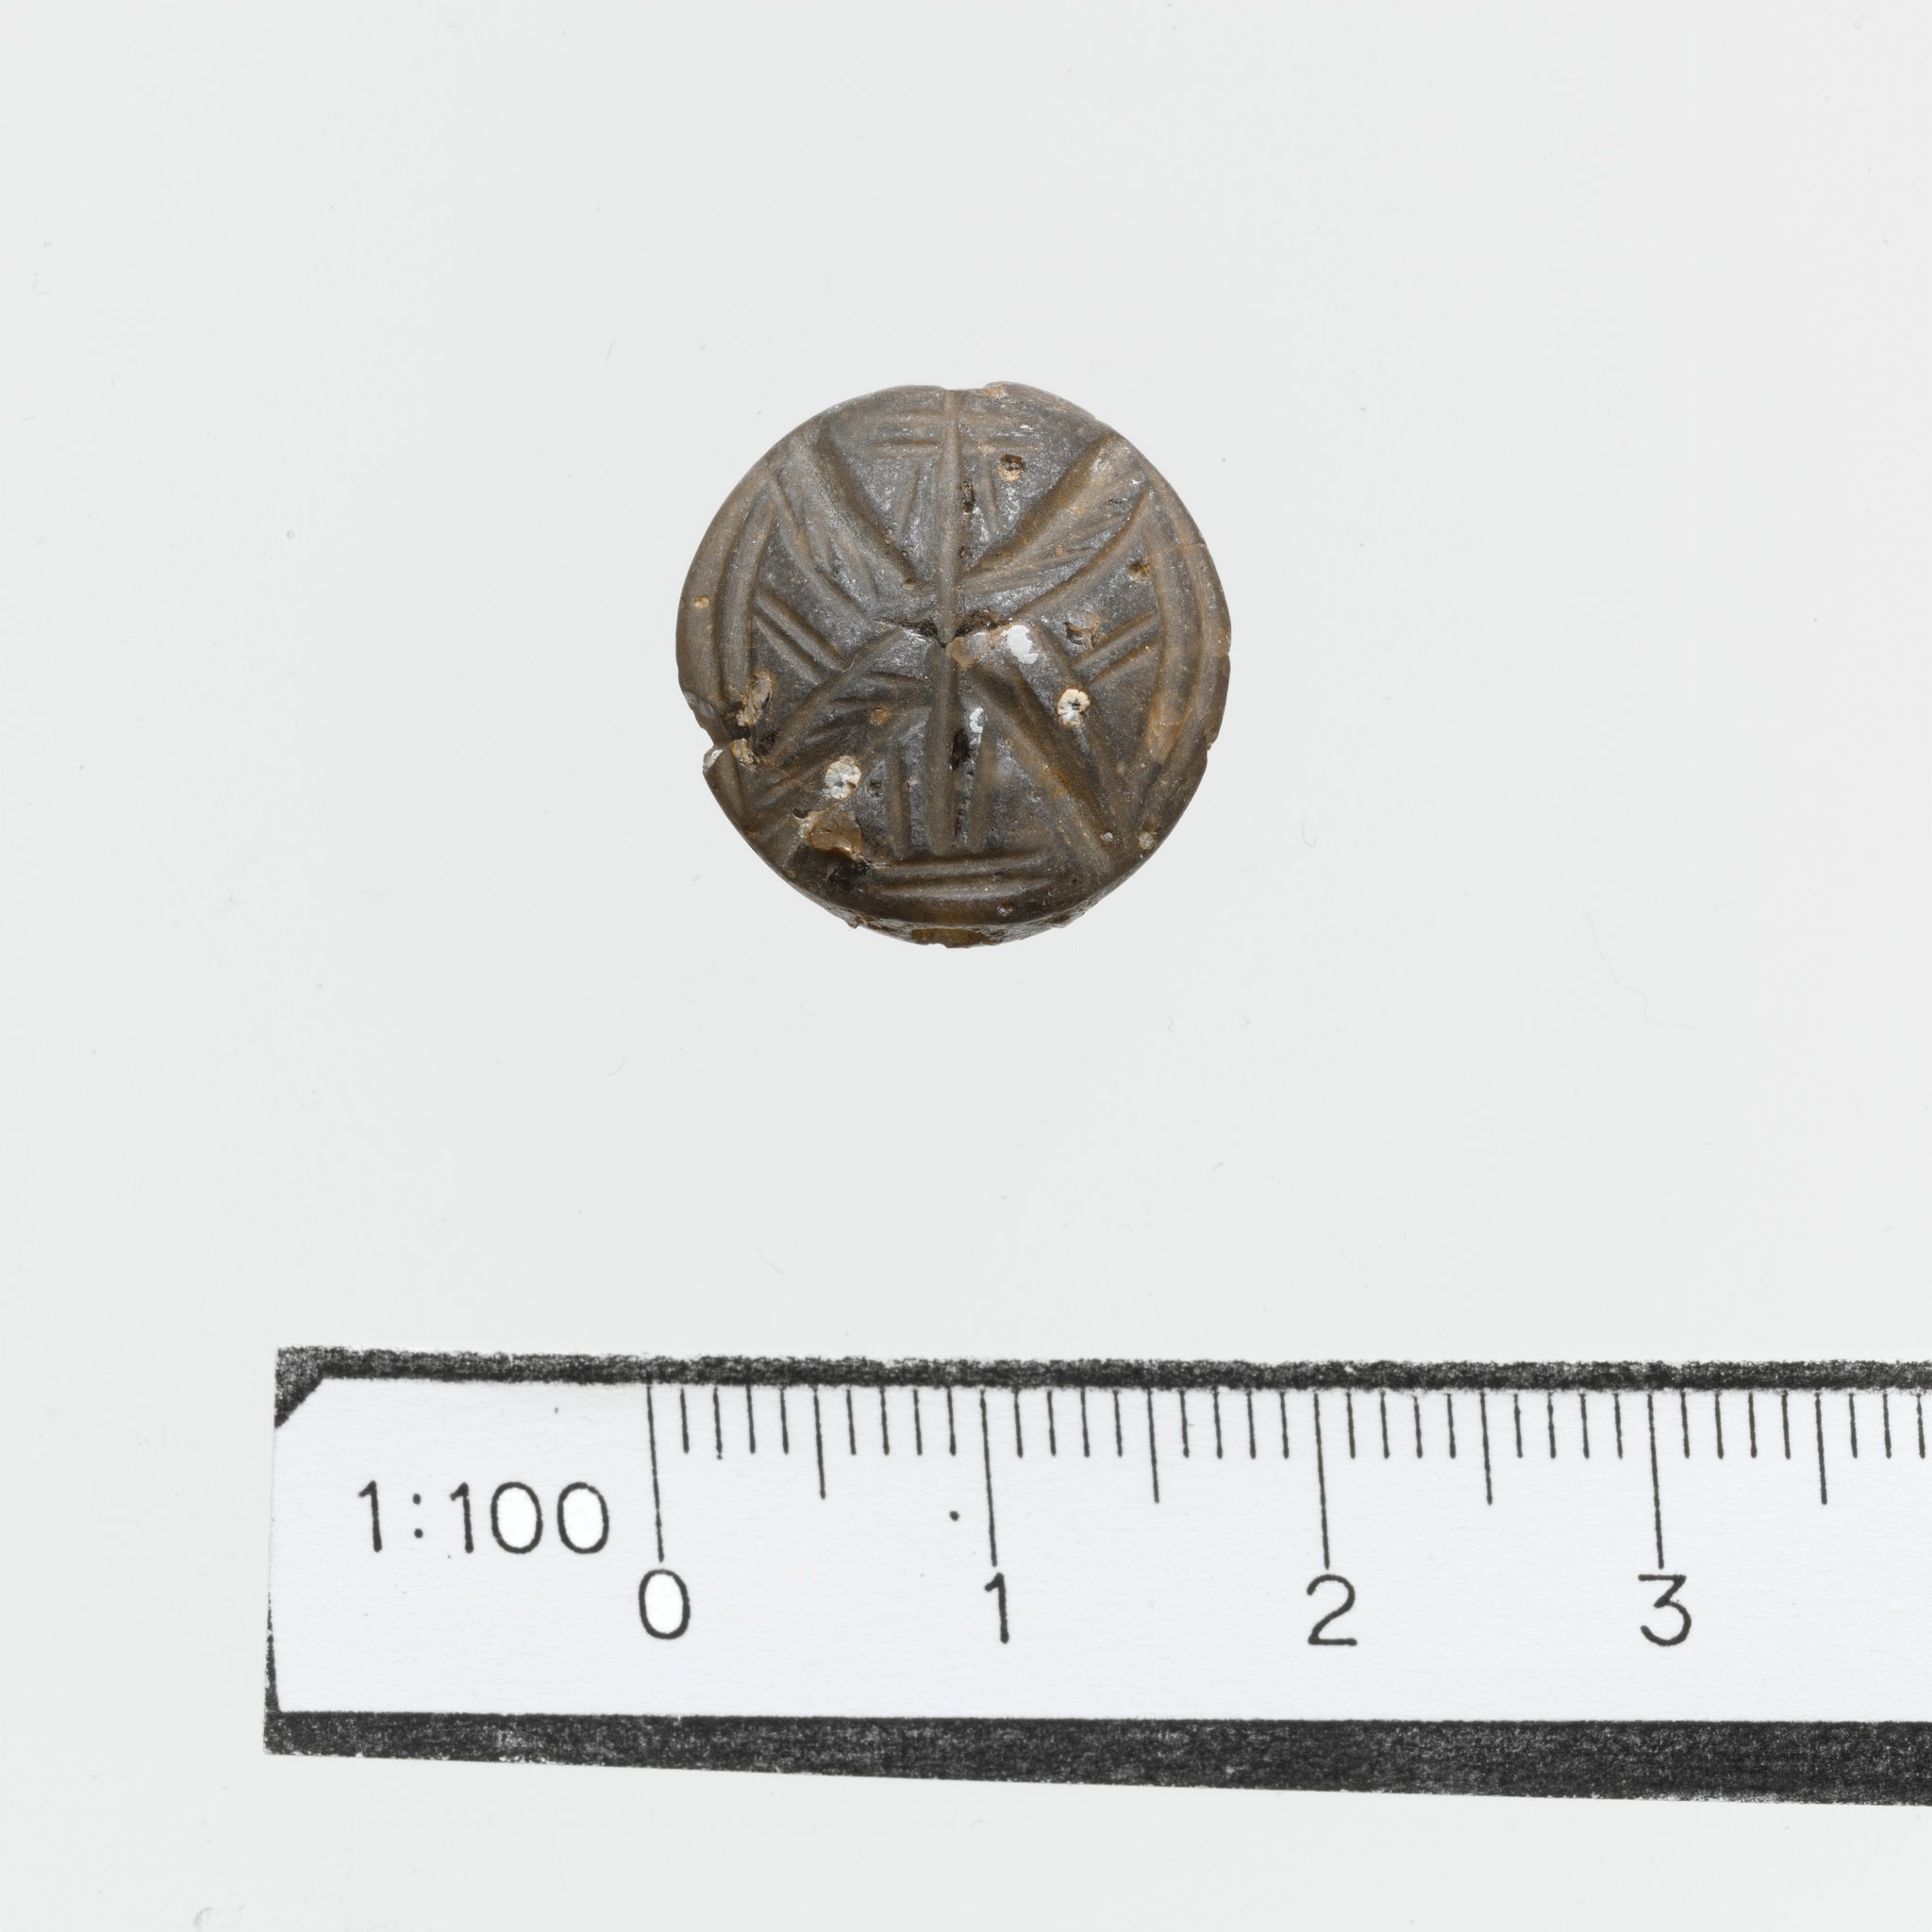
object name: seal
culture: minoan, crete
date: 2000-1450 BCE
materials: quartz